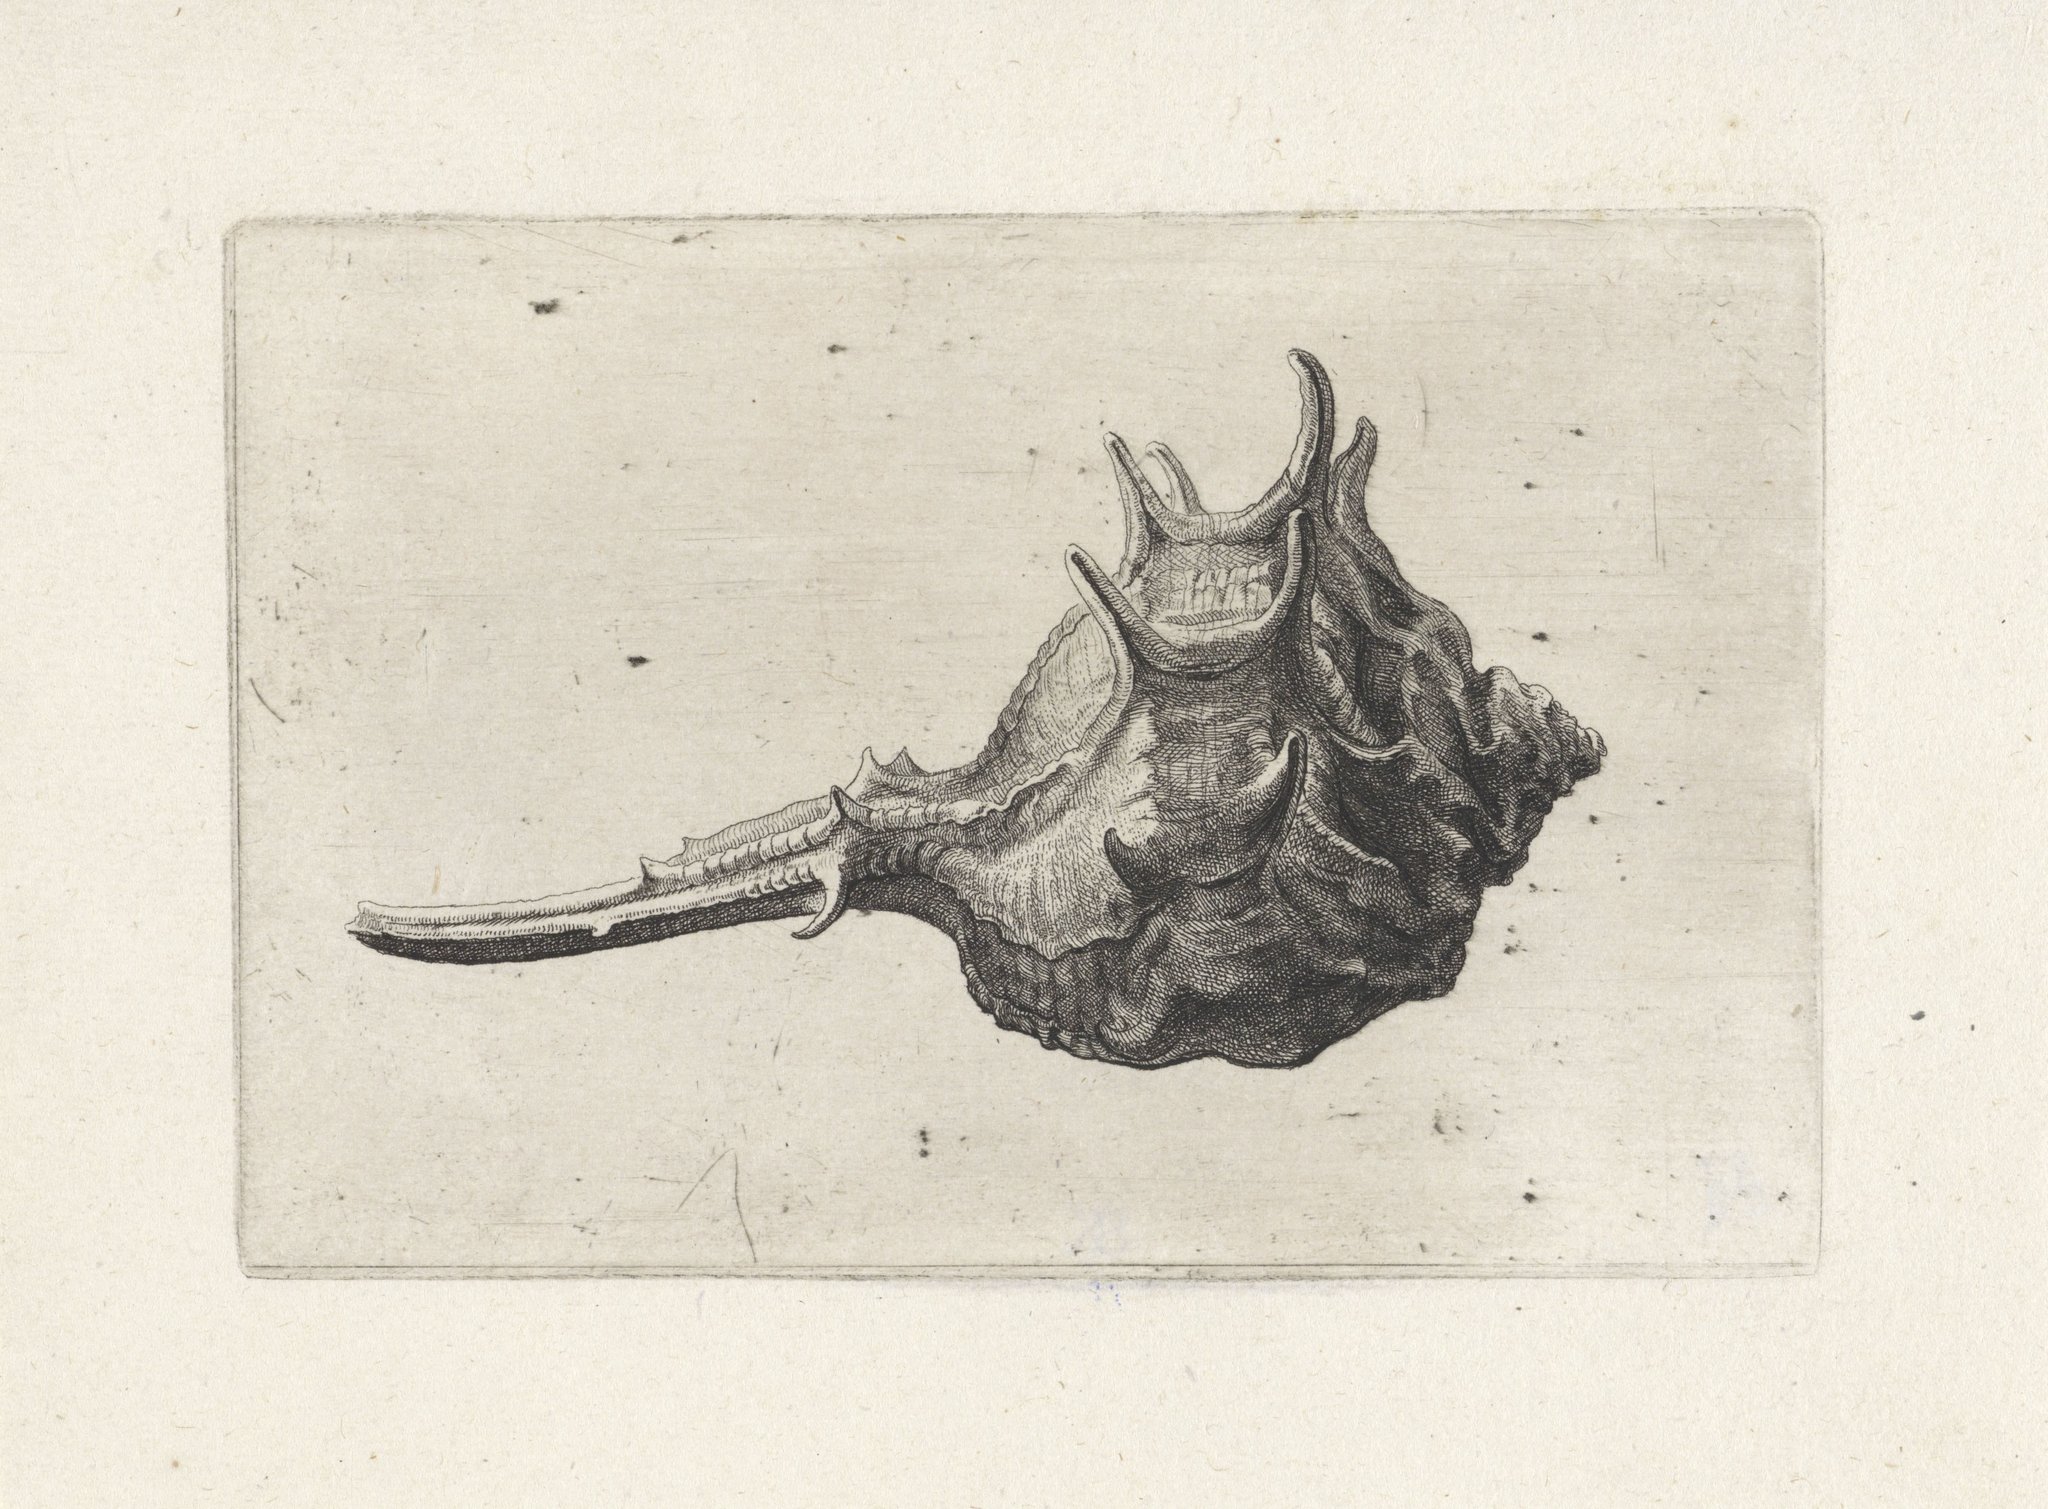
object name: print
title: Schelpen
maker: wenceslaus hollar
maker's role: draughtsman, print maker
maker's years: 1607-1677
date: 1644-1652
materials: paper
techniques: etching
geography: antwerp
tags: molluscs (+ shell, snail-shell etc.)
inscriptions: collector's mark: Lugt 68, collector's mark: Lugt 654, collector's mark: Lugt 384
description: Prent maakt deel uit van een 39-delige serie met verschillende soorten schelpen.